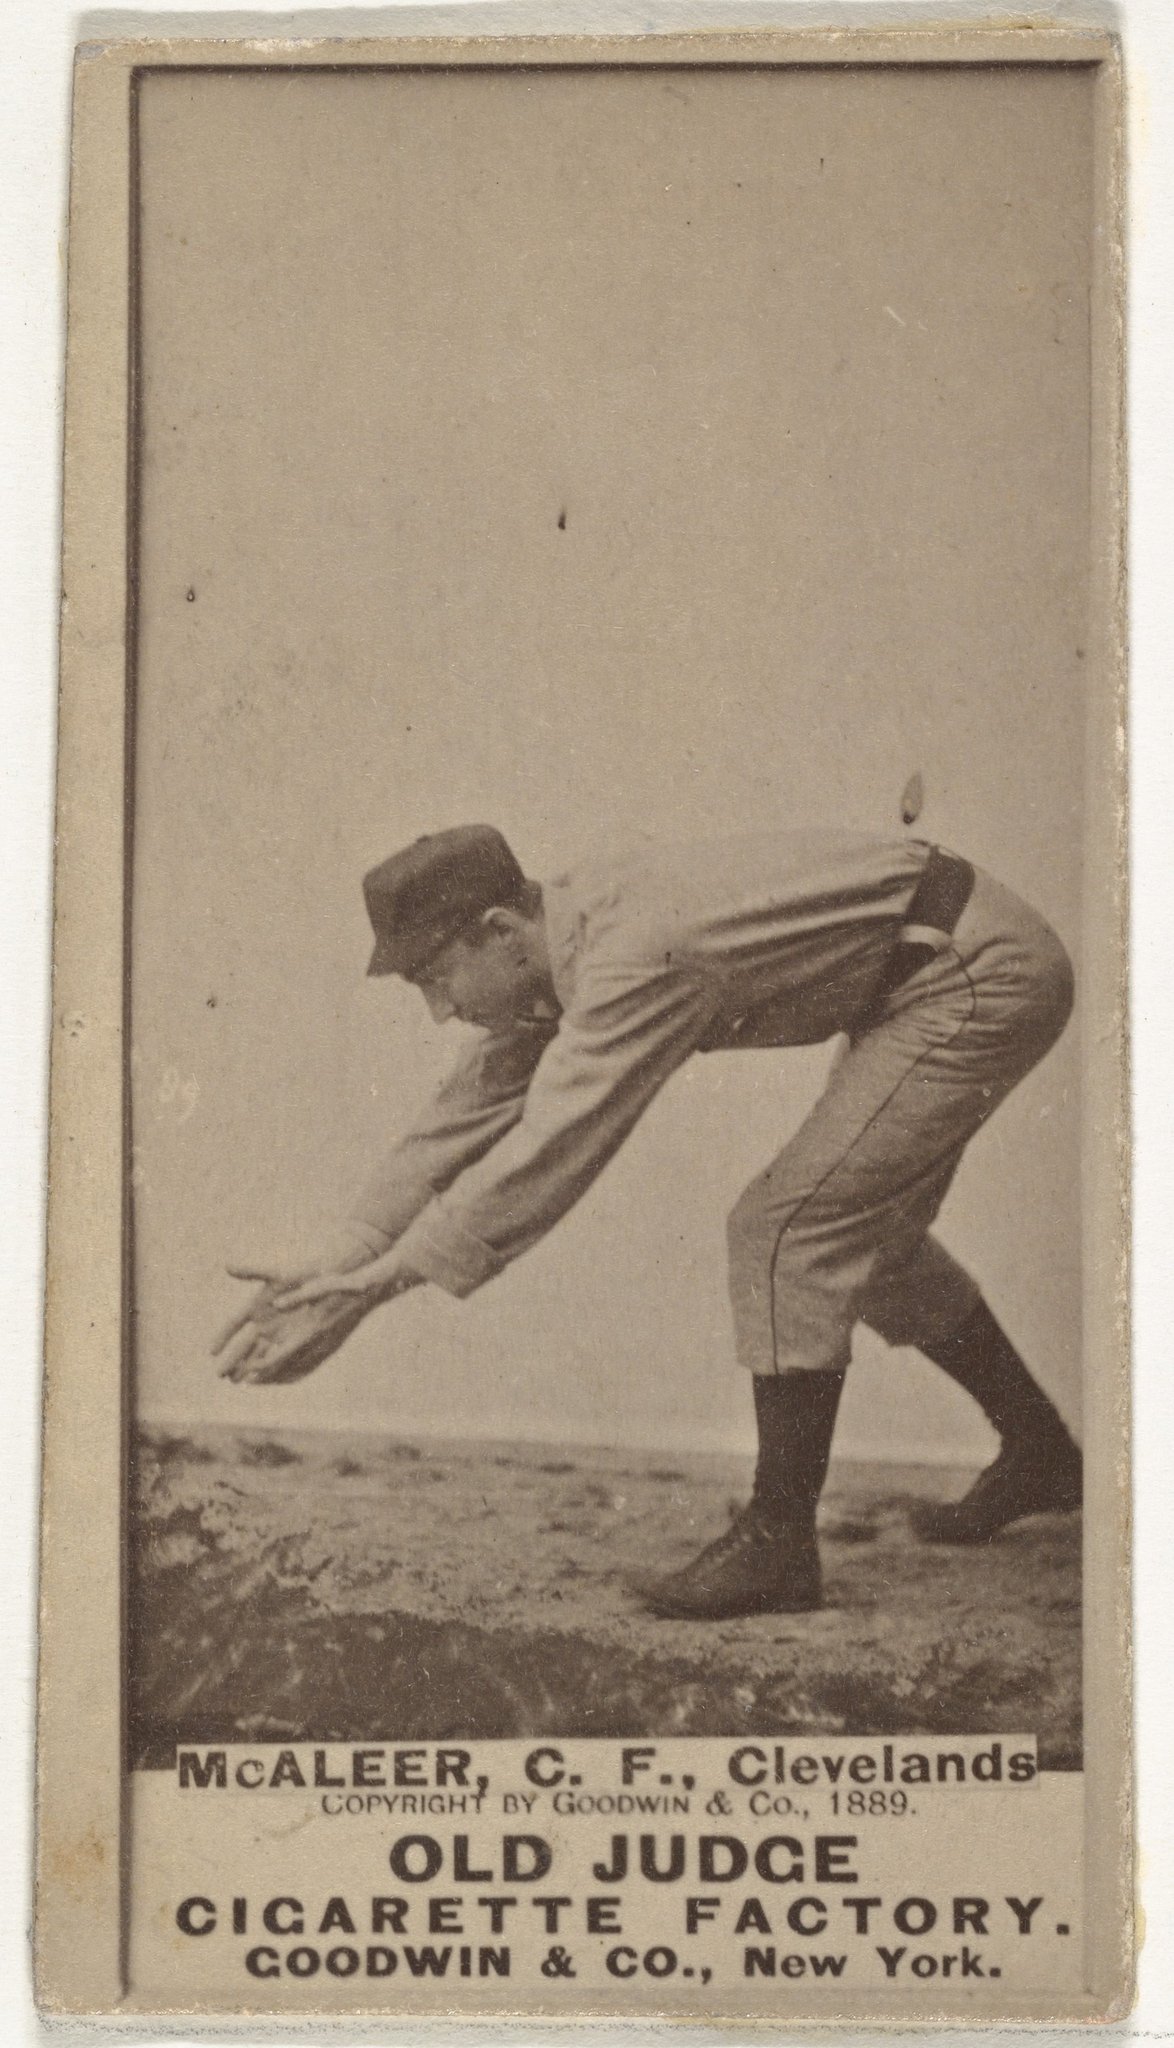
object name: baseball card, photograph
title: Jimmy "Loafer" McAleer, Center Field, Cleveland, from the Old Judge series (N172) for Old Judge Cigarettes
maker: goodwin & company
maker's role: publisher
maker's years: 1850-1950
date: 1889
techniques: albumen silver print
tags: men,portraits,baseball,athletes